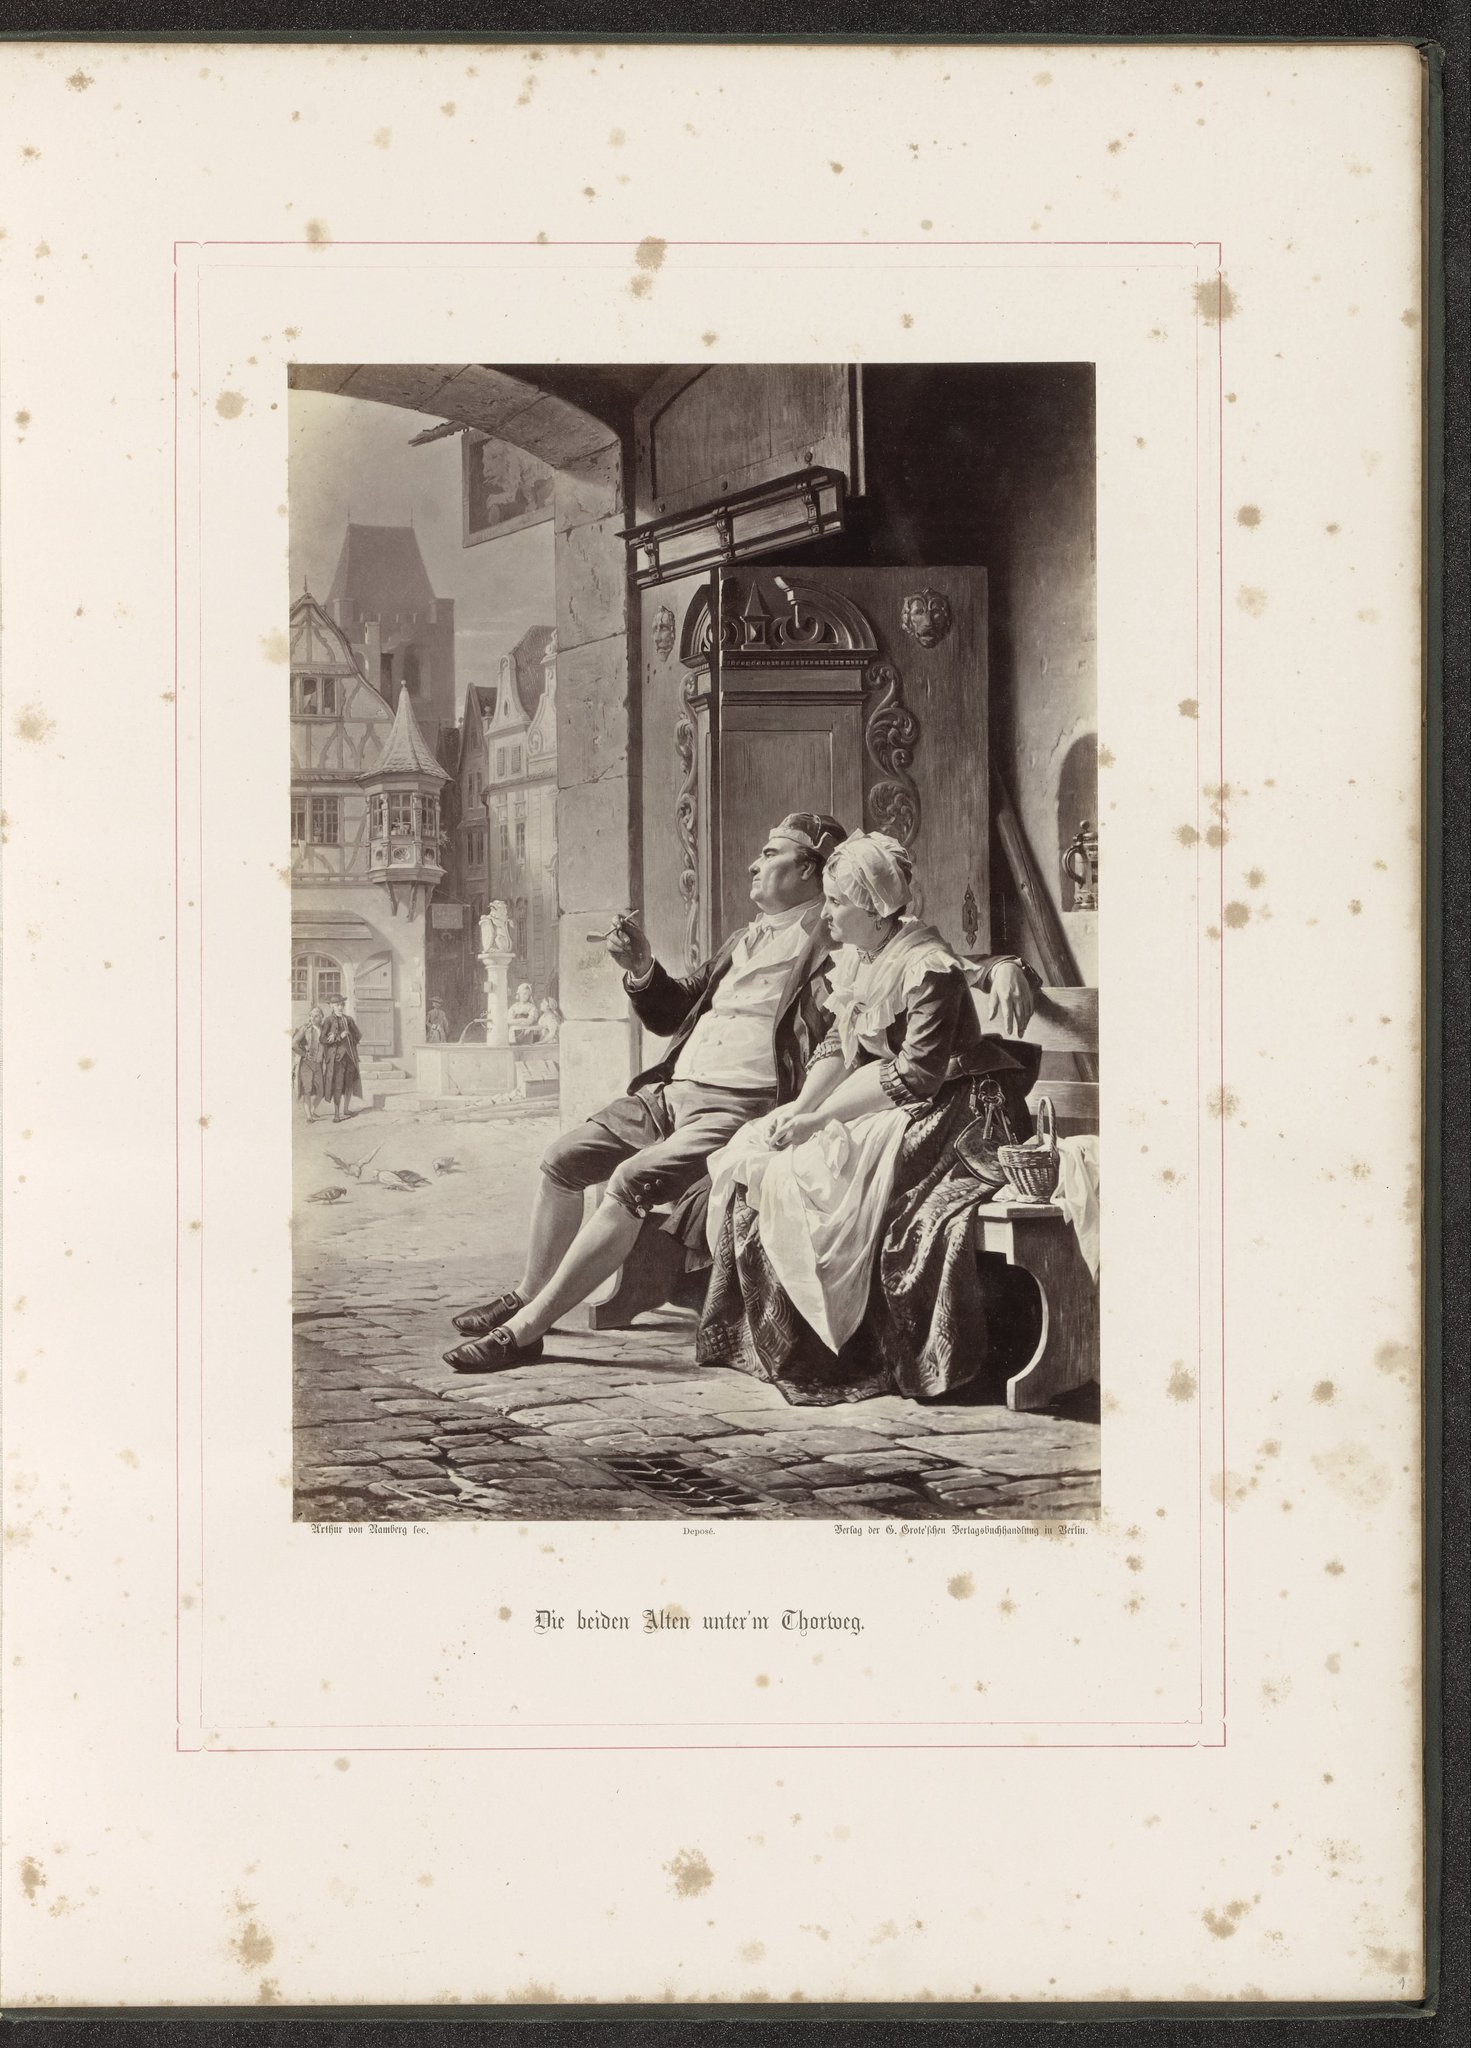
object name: reproduction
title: Fotoreproductie van een schilderij van A.G. von Ramberg, voorstellend de ouders van Hermann zittend bij een poort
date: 1871-1872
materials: photographic support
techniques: albumen print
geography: berlin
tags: marriage, married couple, 'matrimonium', gate, entrance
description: Onderdeel van Album met fotoreproducties van schilderijen van A.G. von Ramberg naar het werk 'Hermann und Dorothea' van J.W. von Goethe.